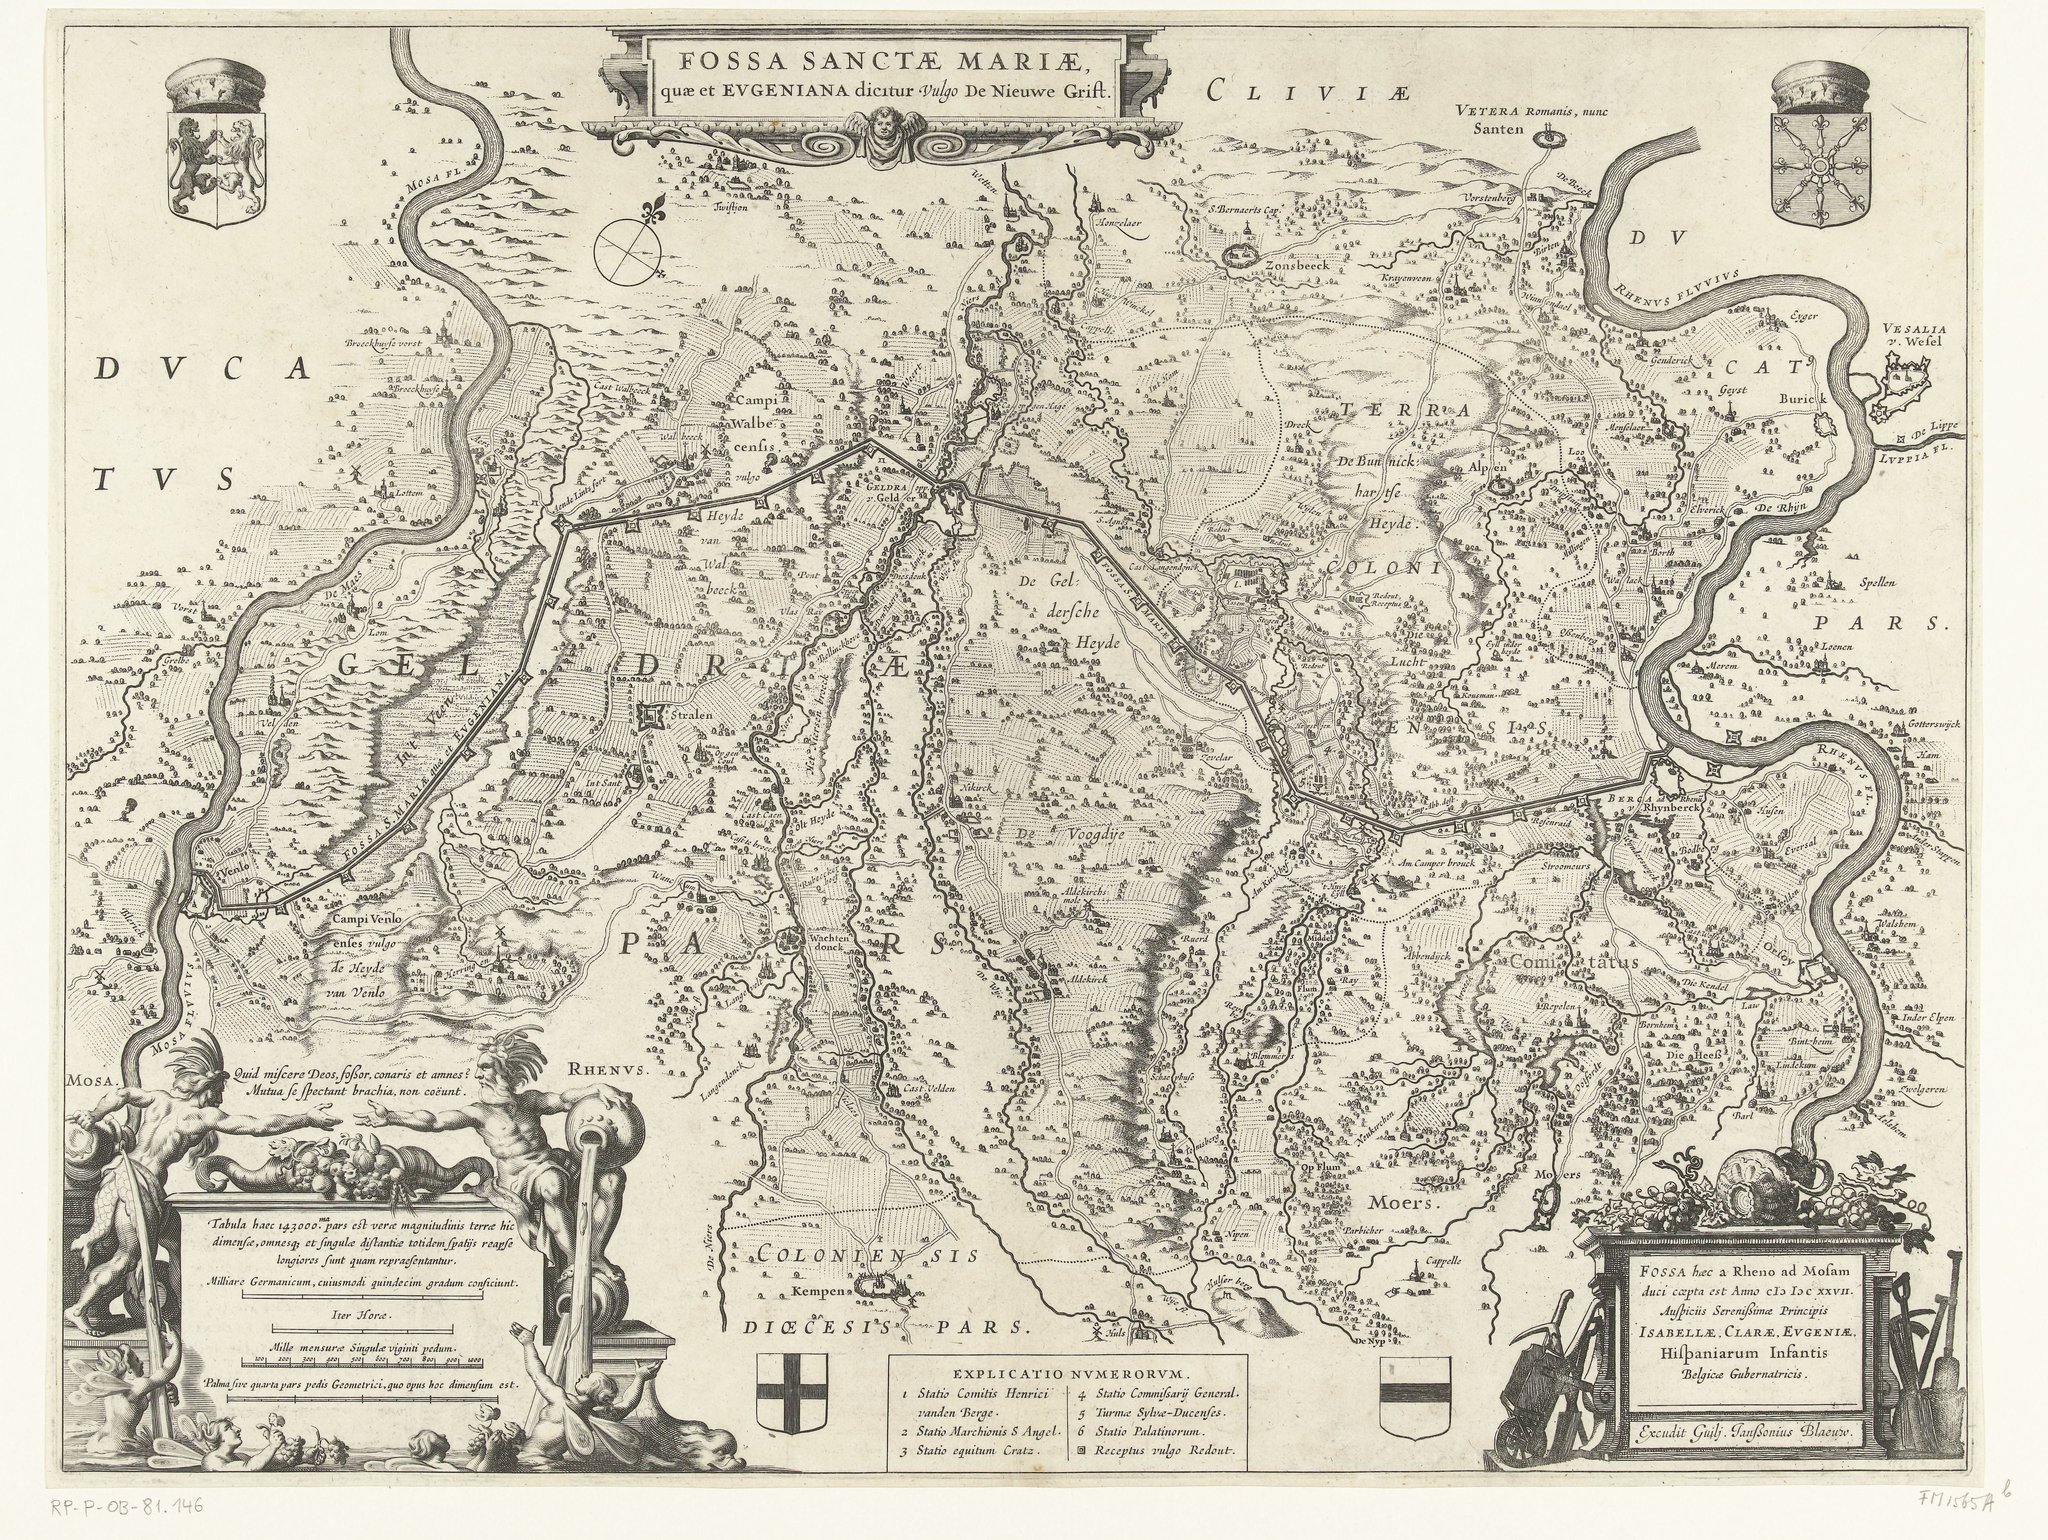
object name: print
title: Kanaal Fossa Eugeniana tussen Rijn en Maas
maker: Anonymous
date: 1627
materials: paper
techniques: engraving, etching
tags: infante van spanje isabella clara eugenia, construction of canal, maps of separate countries or regions, river personified, 'fiumi' (ripa) - hh - ideal landscapes, coat of arms (as symbol of the state, etc.) (+ province; provincial), guelders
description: Kaart met het kanaal genaamd Fossa Eugeniana tussen Rijnberg aan de Rijn en Venlo aan de Maas. Boven, in het midden, de titelcartouche. Rechtsonder een cartouche met Latijnse tekst. Onder, in het midden, een kader met legenda 1-6. Linksonder een cartouche met vier schaalstokken, versierd met personificaties van de Rijn en de Maas die elkaar de hand reiken. Linksboven het wapen van het hertogdom Gelre, rechtsboven het wapen van het hertogdom Kleef. Onder, rechts van het midden, het wapen van het vorstendom Meurs. Onder, links van het midden, het wapen van het aartsbisdom Keulen.